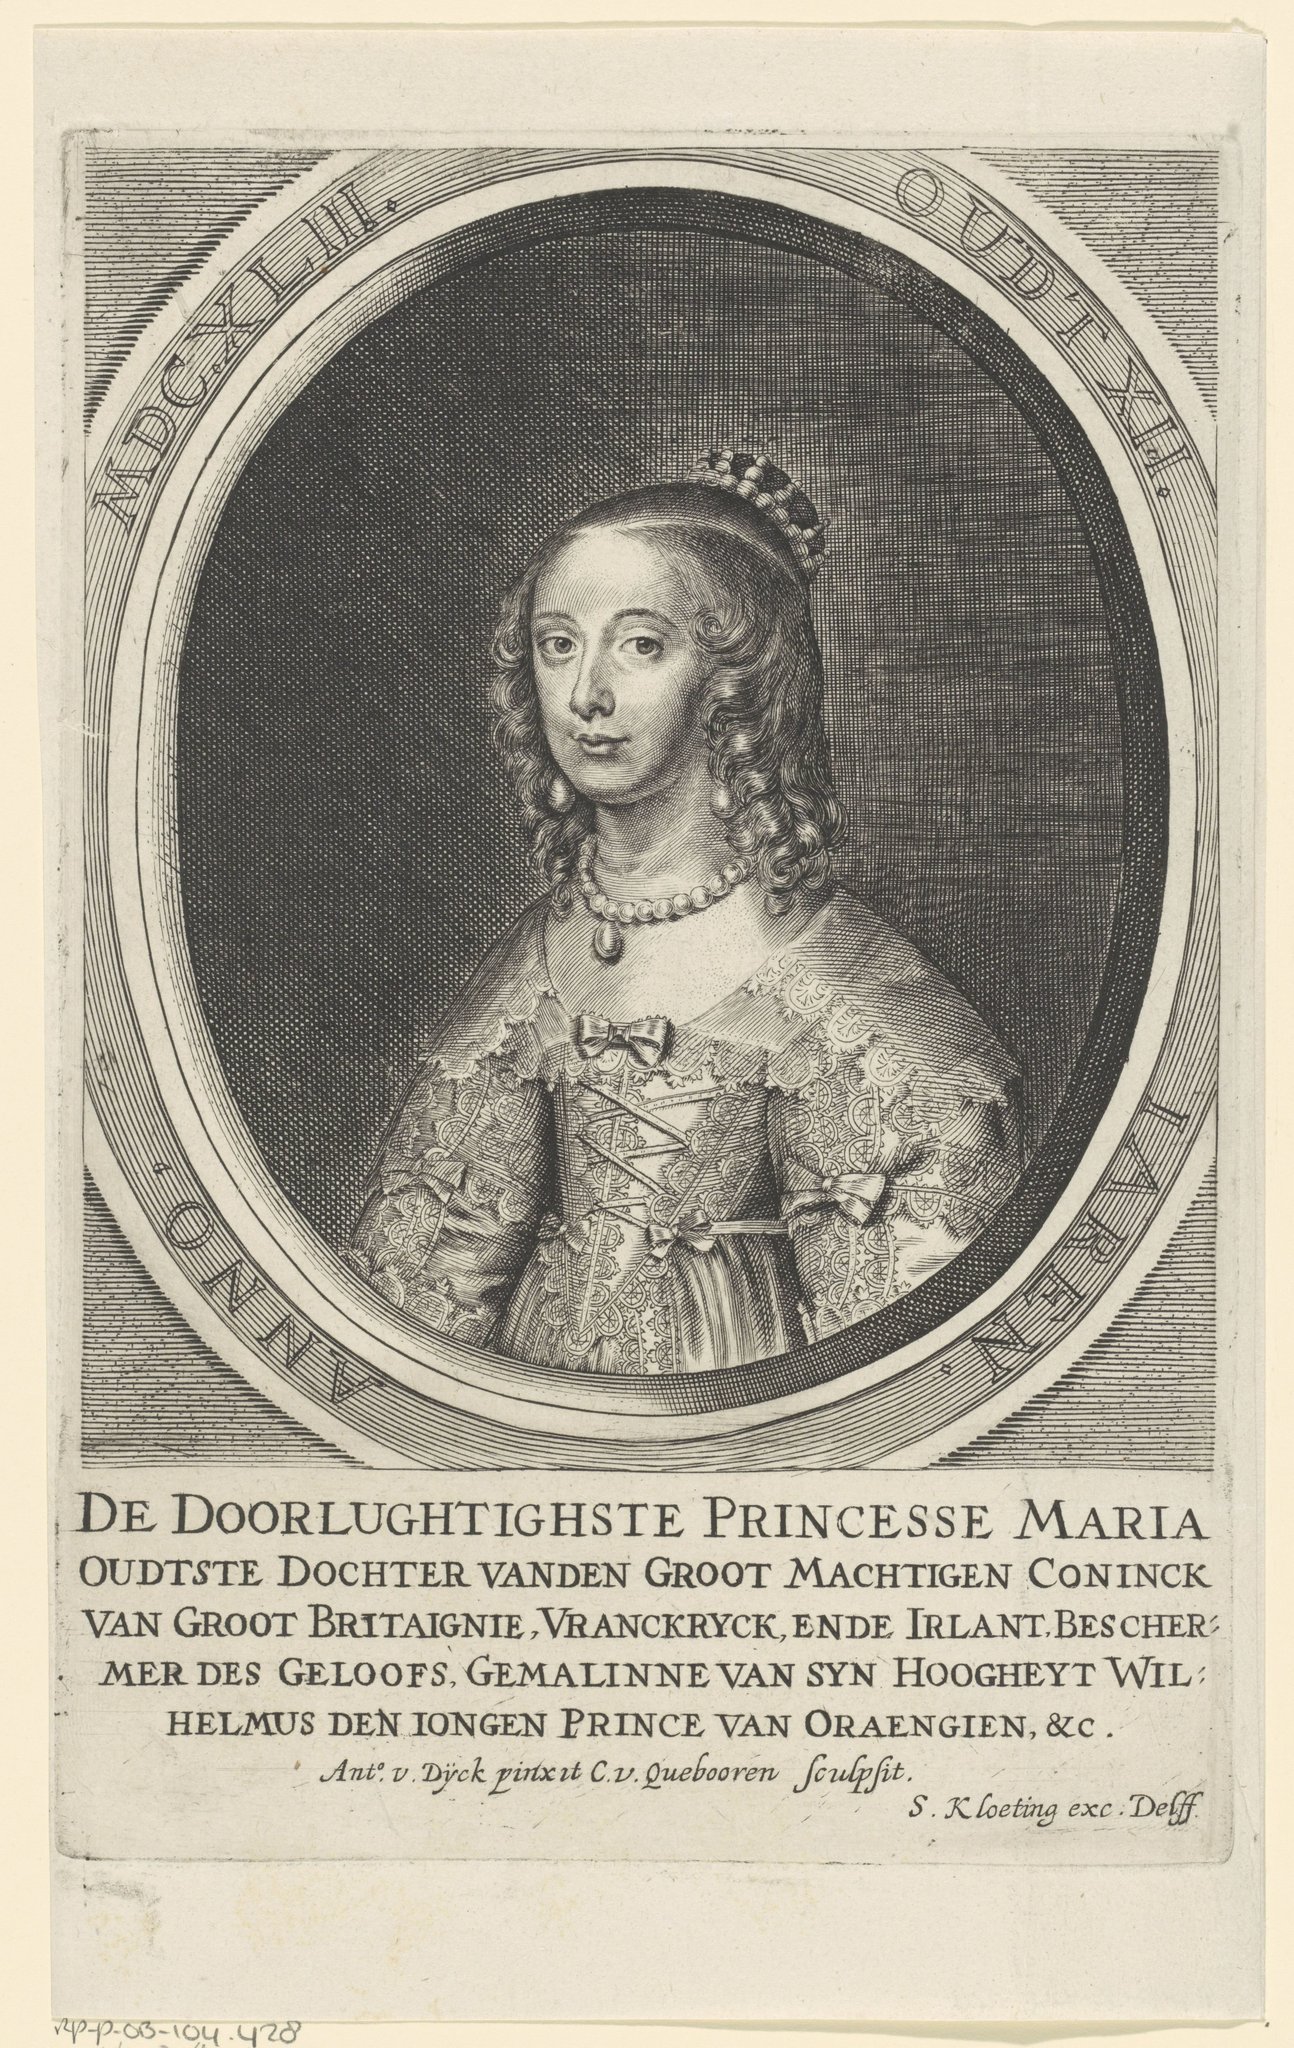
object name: print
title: Portret van Maria Henrietta Stuart, op 12-jarige leeftijd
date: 1645-1674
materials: paper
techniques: engraving, etching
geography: delft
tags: london, mary henrietta stuart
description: Portret van Maria Henrietta in een ovaal met randschrift. In de ondermarge vijf regels Nederlandse tekst.